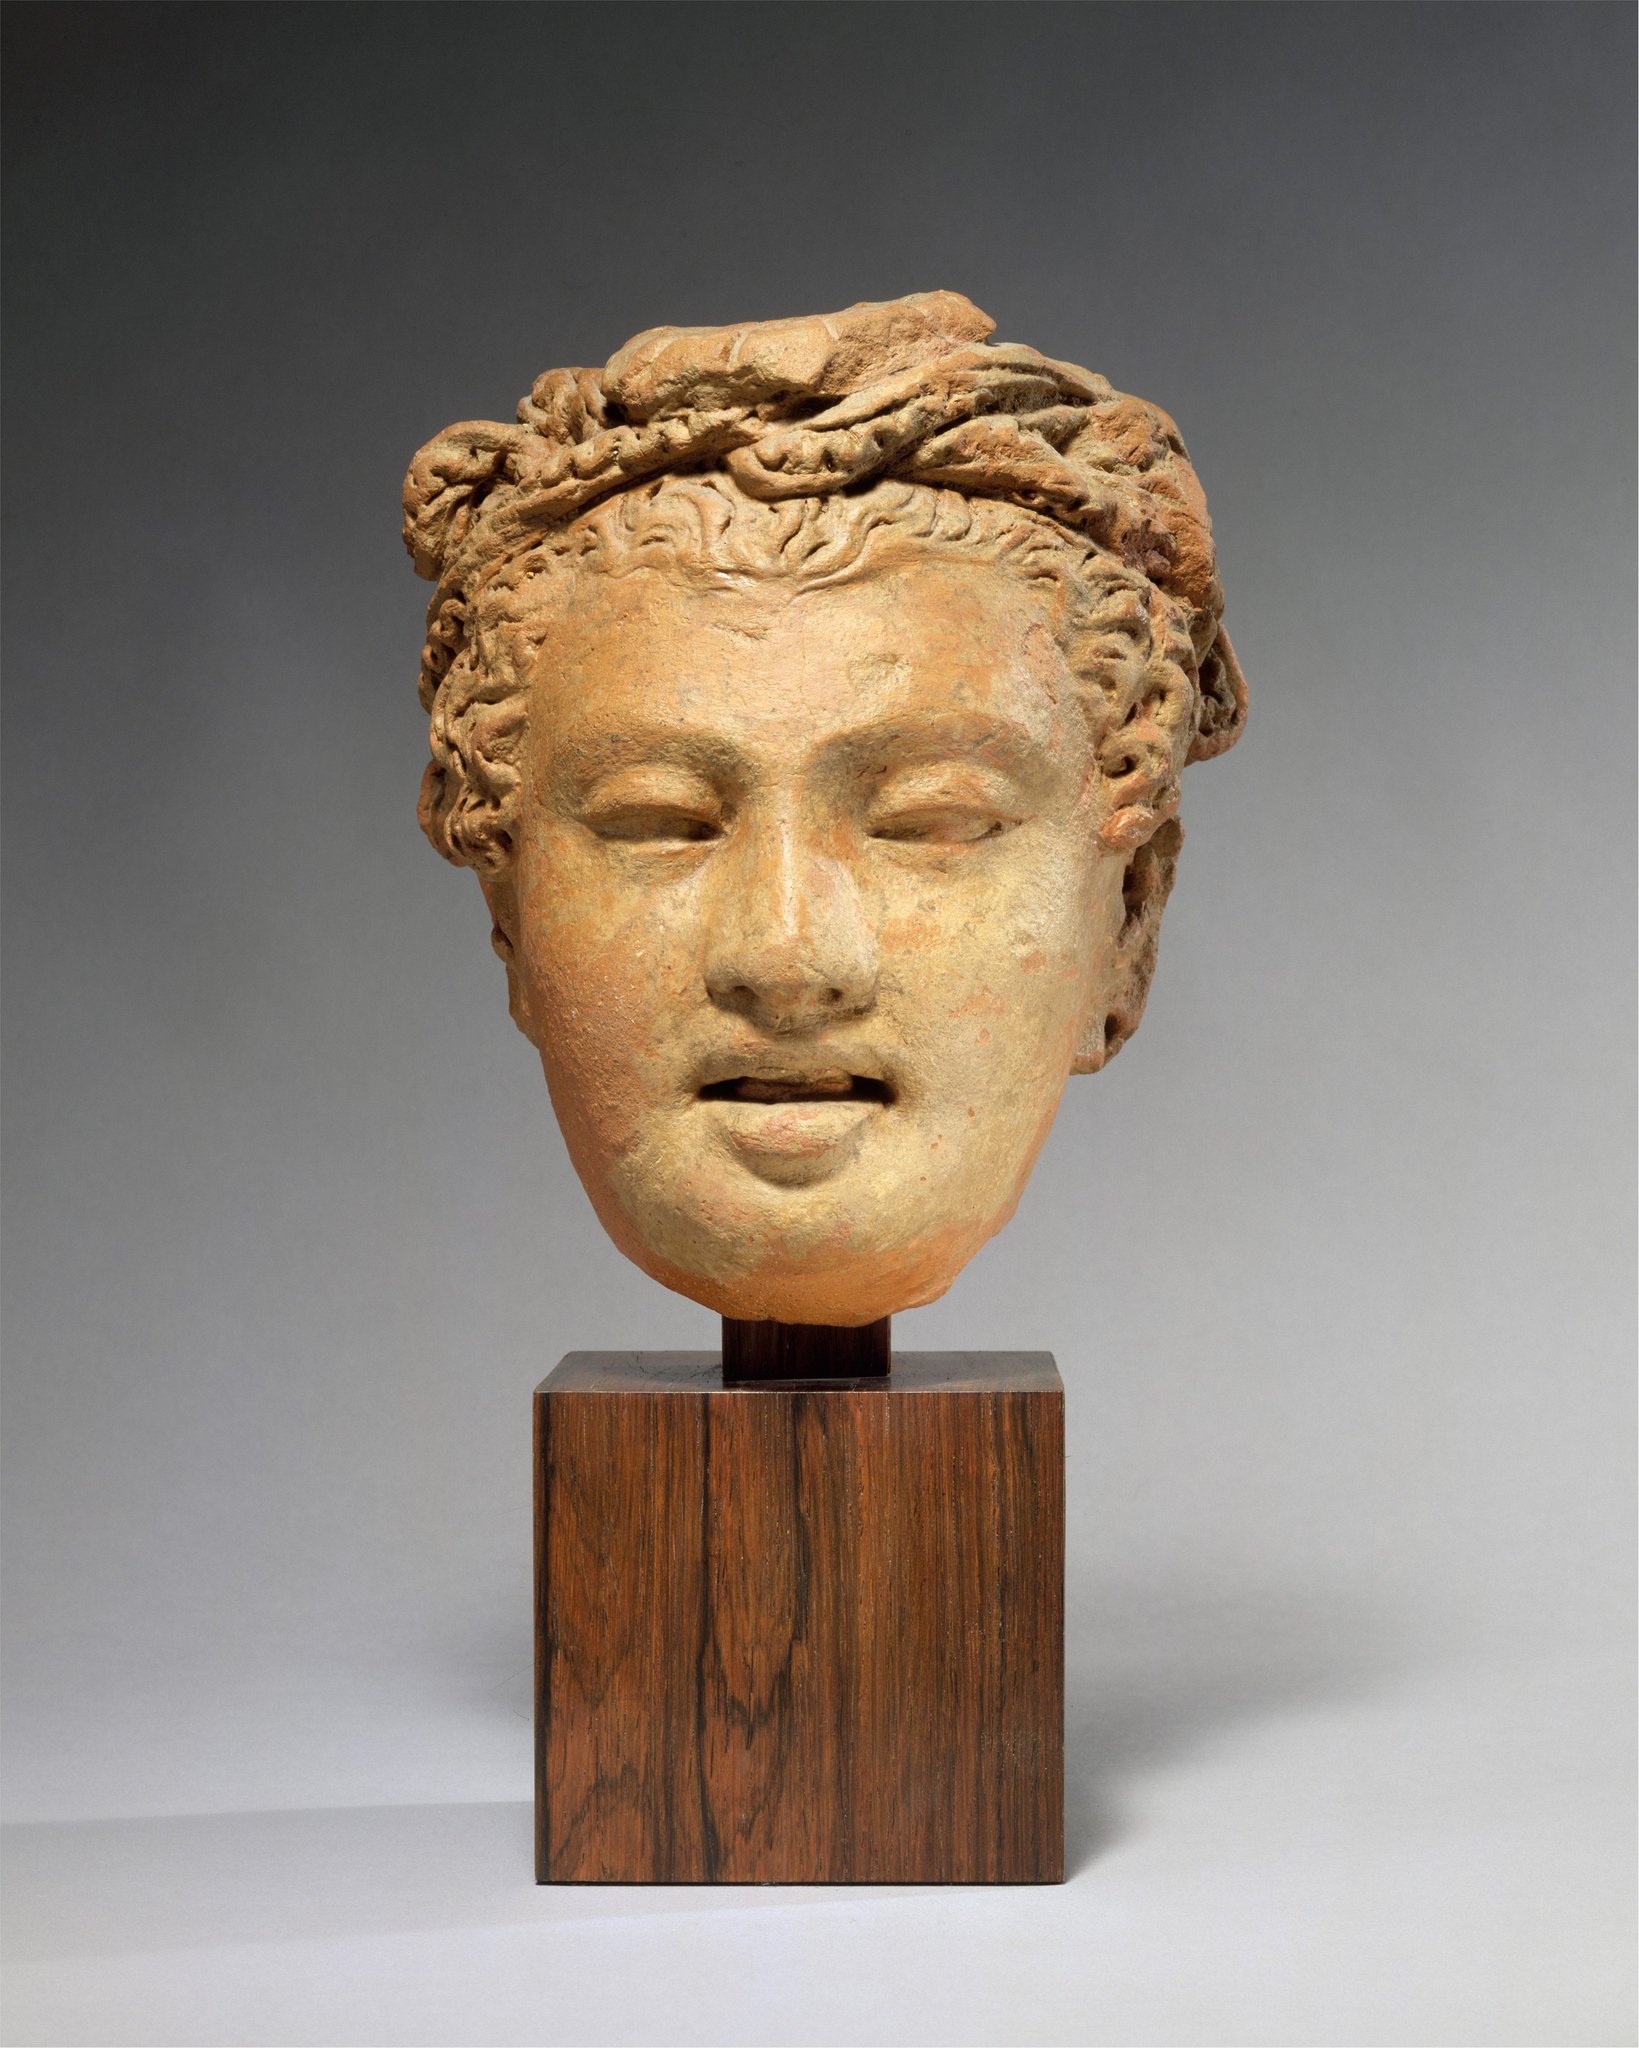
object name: head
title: Head of a Male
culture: gandhara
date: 301-400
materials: terracotta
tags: gandhara,heads,men